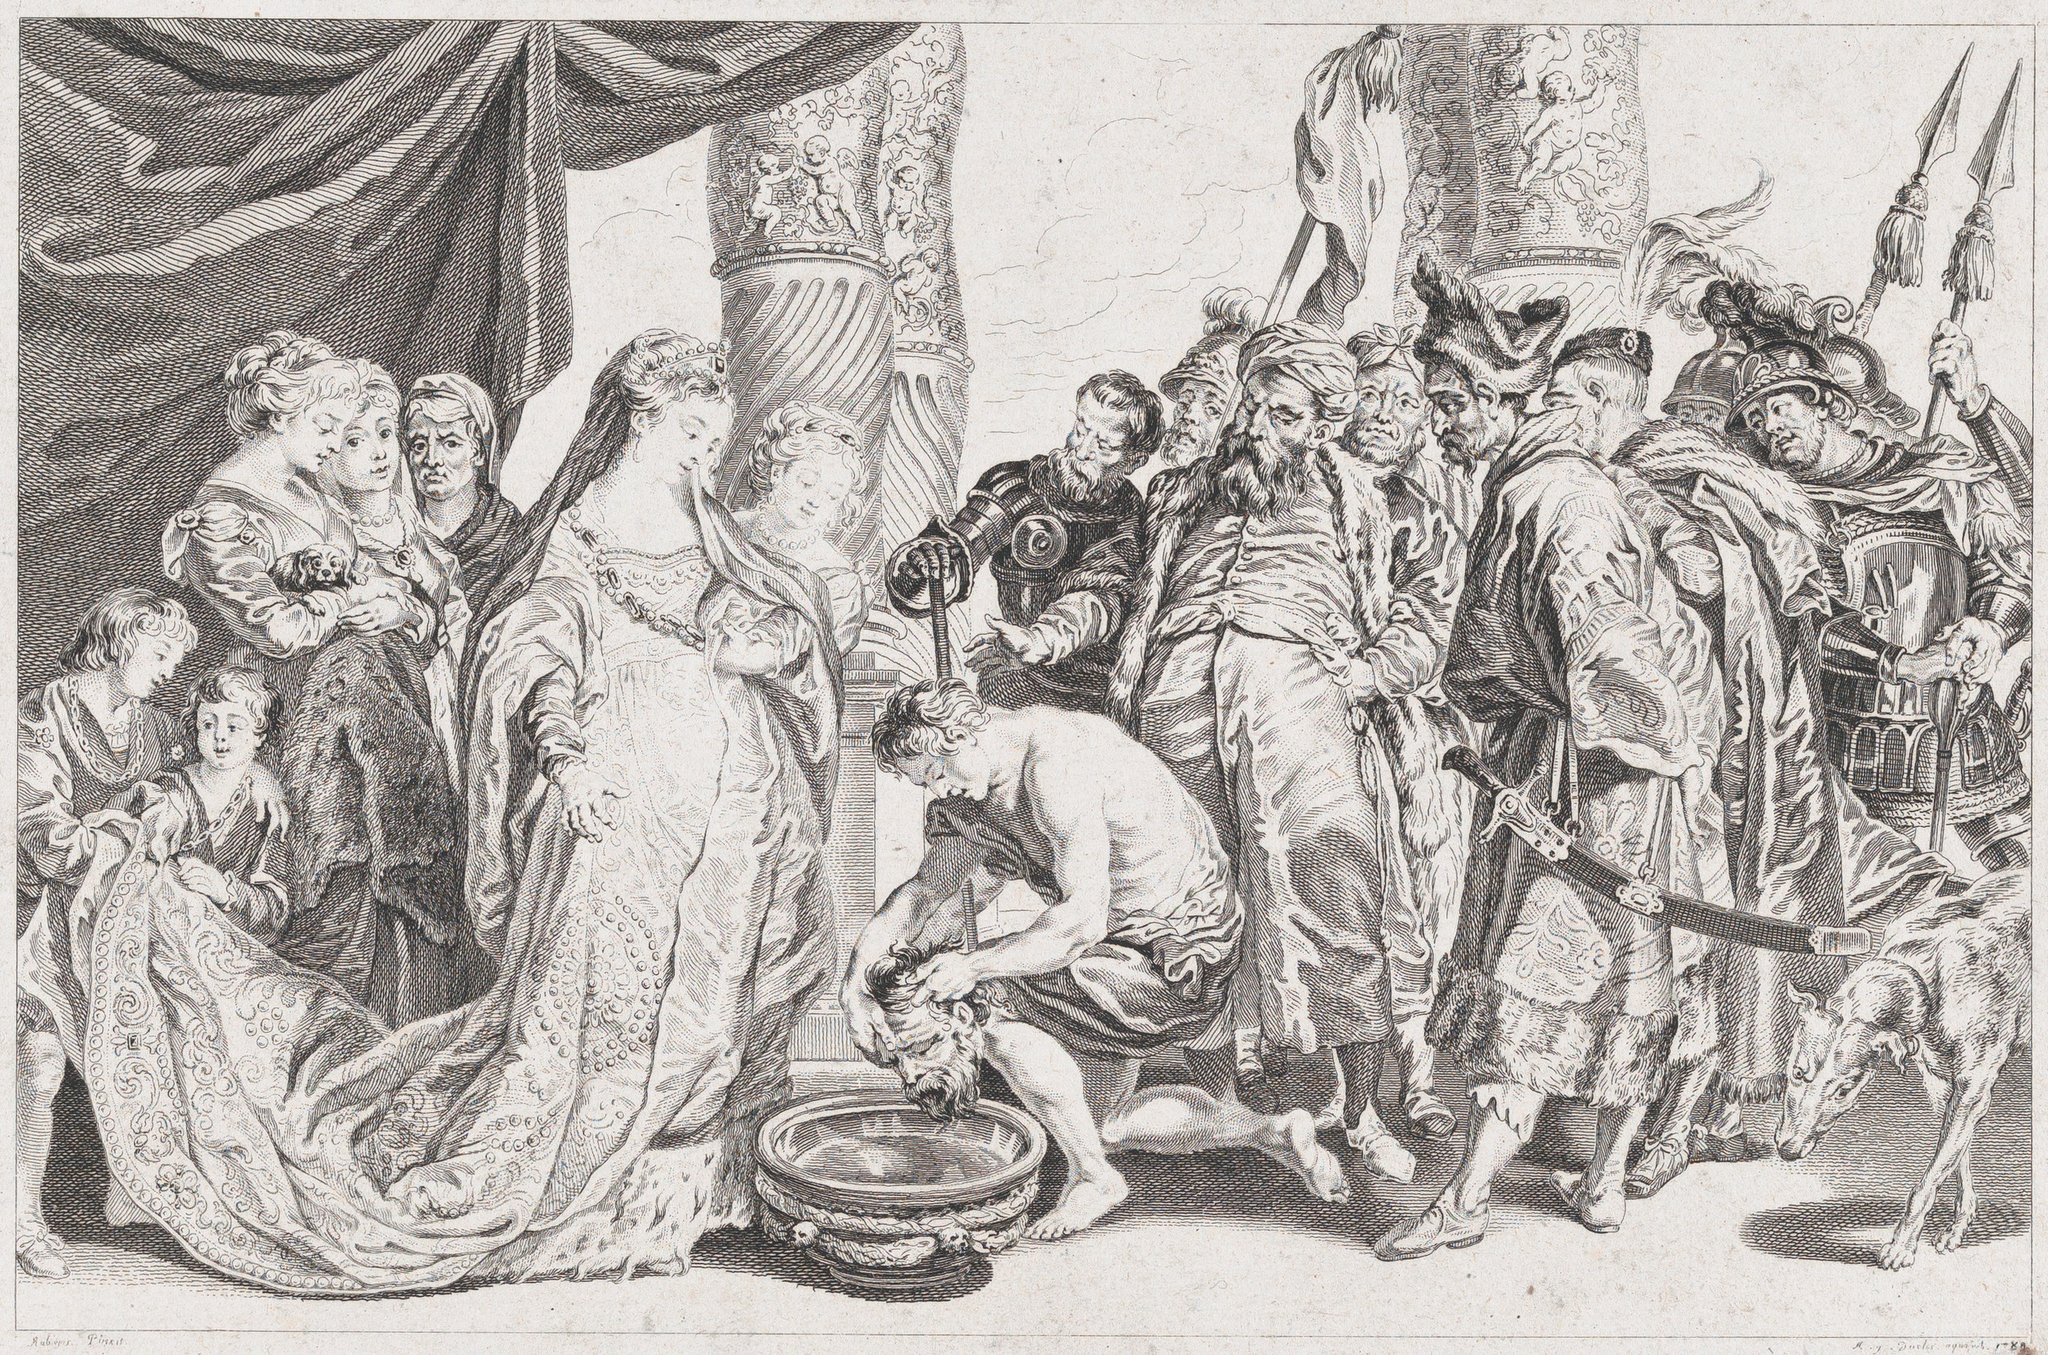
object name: print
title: The Head of Cyrus brought to Queen Tomyris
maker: antoine jean duclos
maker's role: artist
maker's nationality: french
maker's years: 1742-1795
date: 1785-1789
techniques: etching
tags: soldiers,queens,heads,men,women